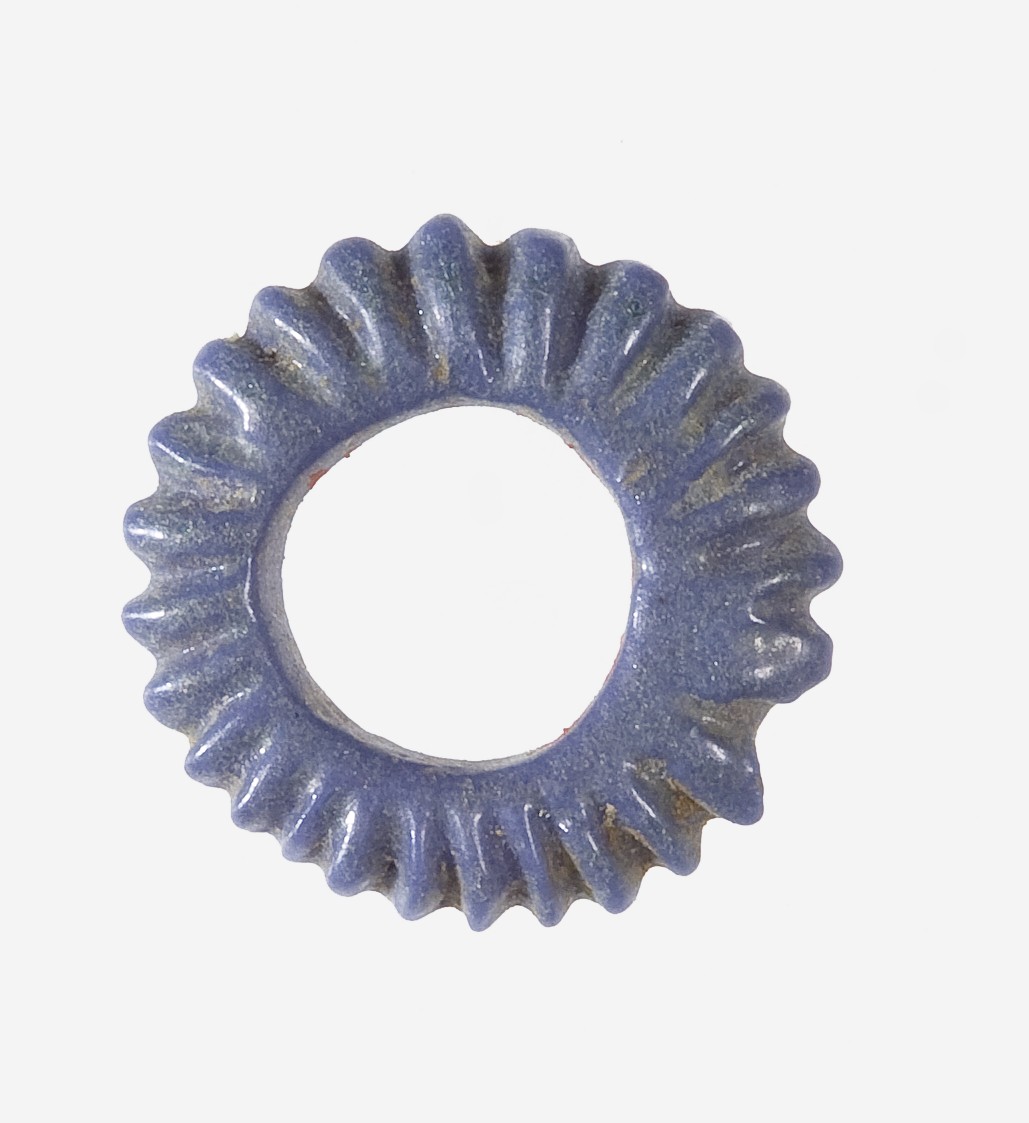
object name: pendant, ring shaped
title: Ring Pendant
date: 1390-1352 BCE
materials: faience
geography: egypt